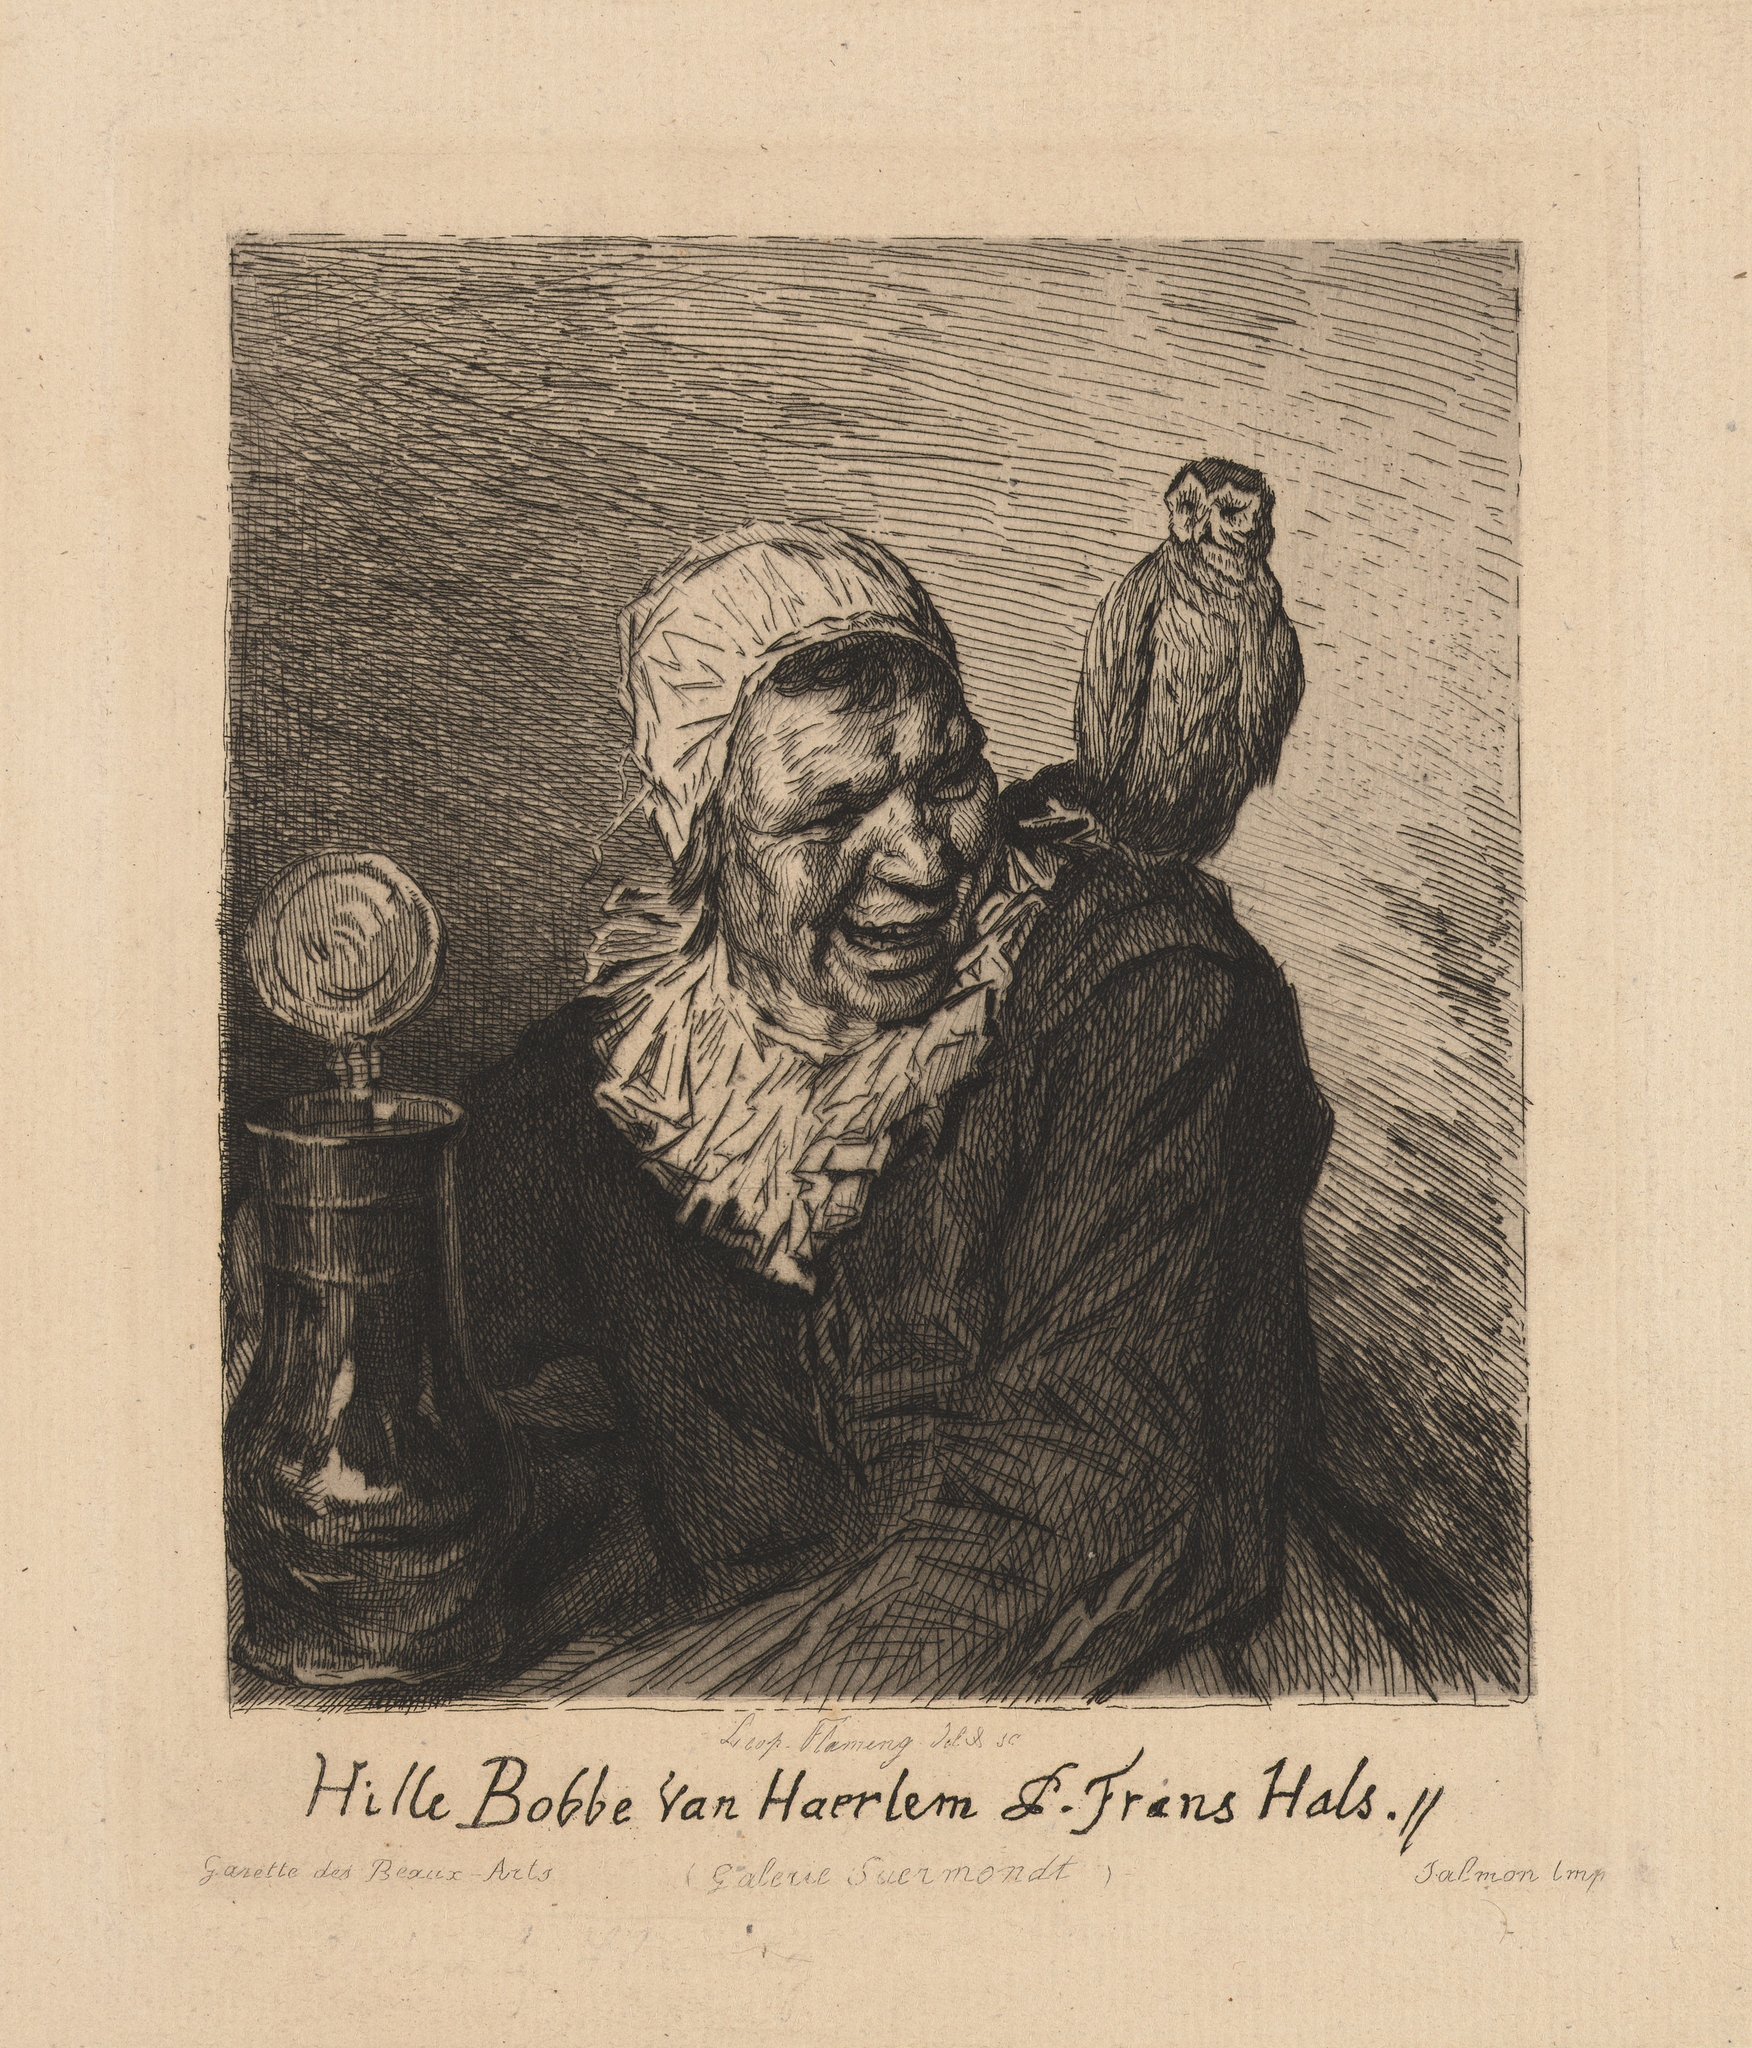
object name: print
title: Hille Bobbe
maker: léopold flameng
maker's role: engraver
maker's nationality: french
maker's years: 1831-1911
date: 1869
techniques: etching